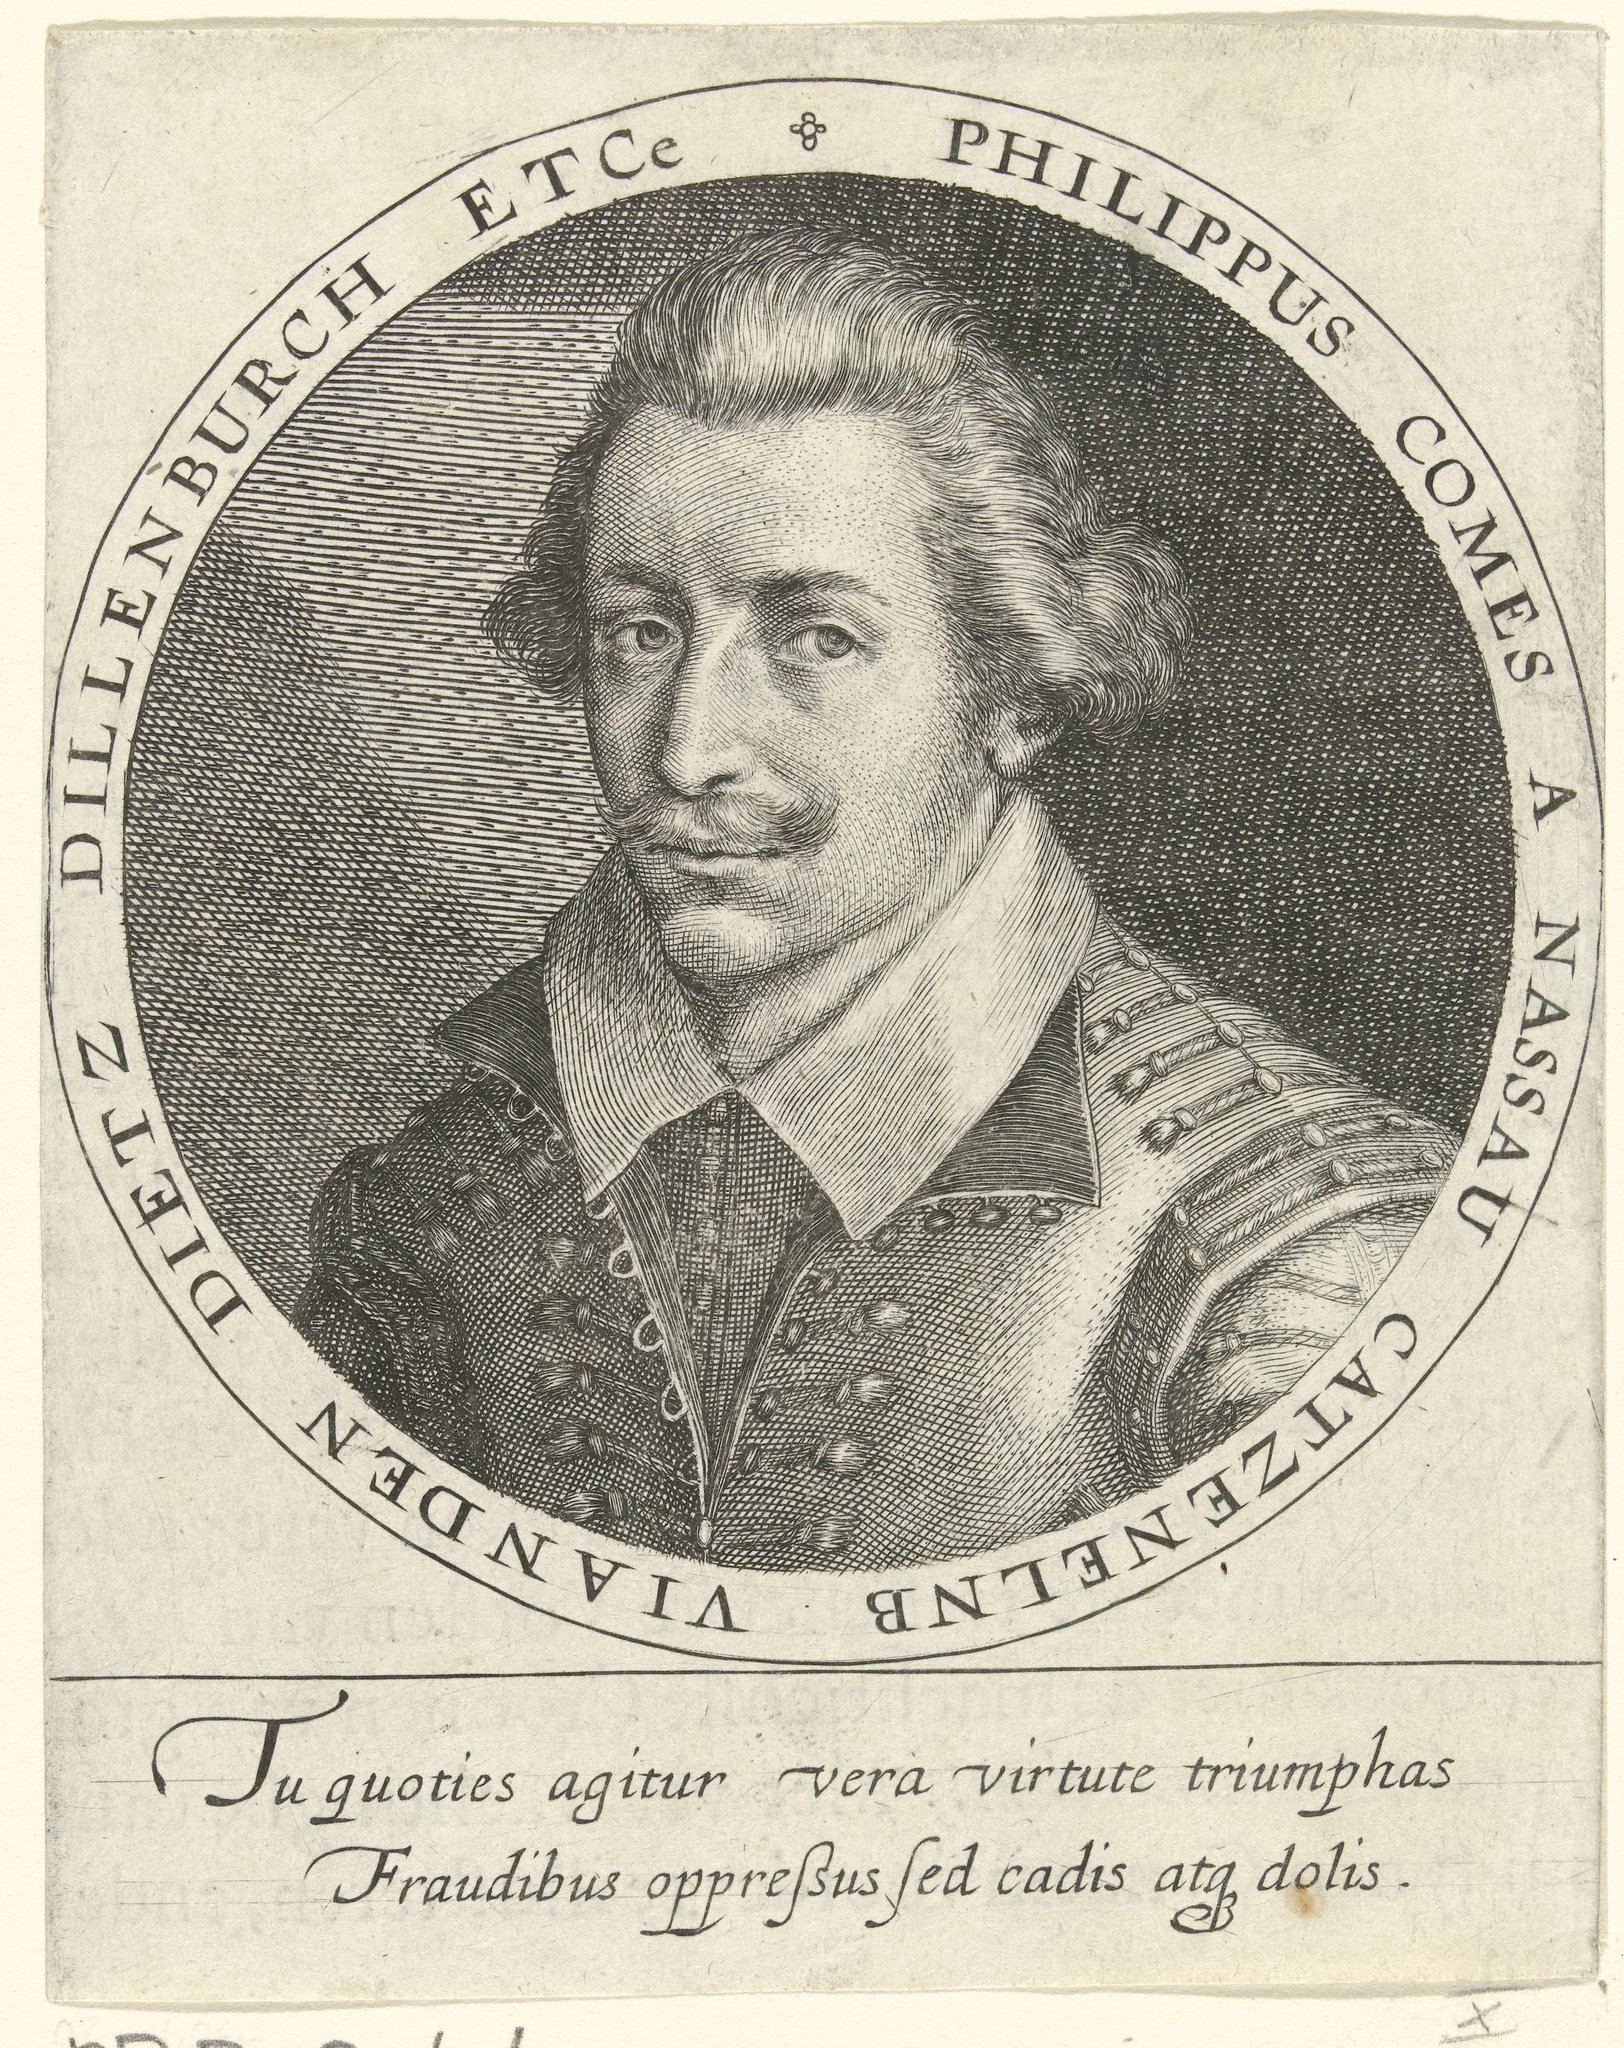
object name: print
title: Portret van Filips van Nassau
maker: crispijn van de passe (i)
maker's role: draughtsman, print maker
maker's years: 1564-1637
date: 1615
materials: paper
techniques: engraving, letterpress printing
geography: utrecht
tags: dillenburg, rijnberg, filips graaf van nassau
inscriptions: collector's mark: Lugt 2228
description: Portret van Filips, graaf van Nassau, Katzenelbogen, Vianden en Dietz. In het randschrift van de omlijsting de naam en functie van de geportretteerde in het Latijn. In de marge een tweeregelig lofdicht in het Latijn. Op de versozijde boekdruk in het Nederlands.